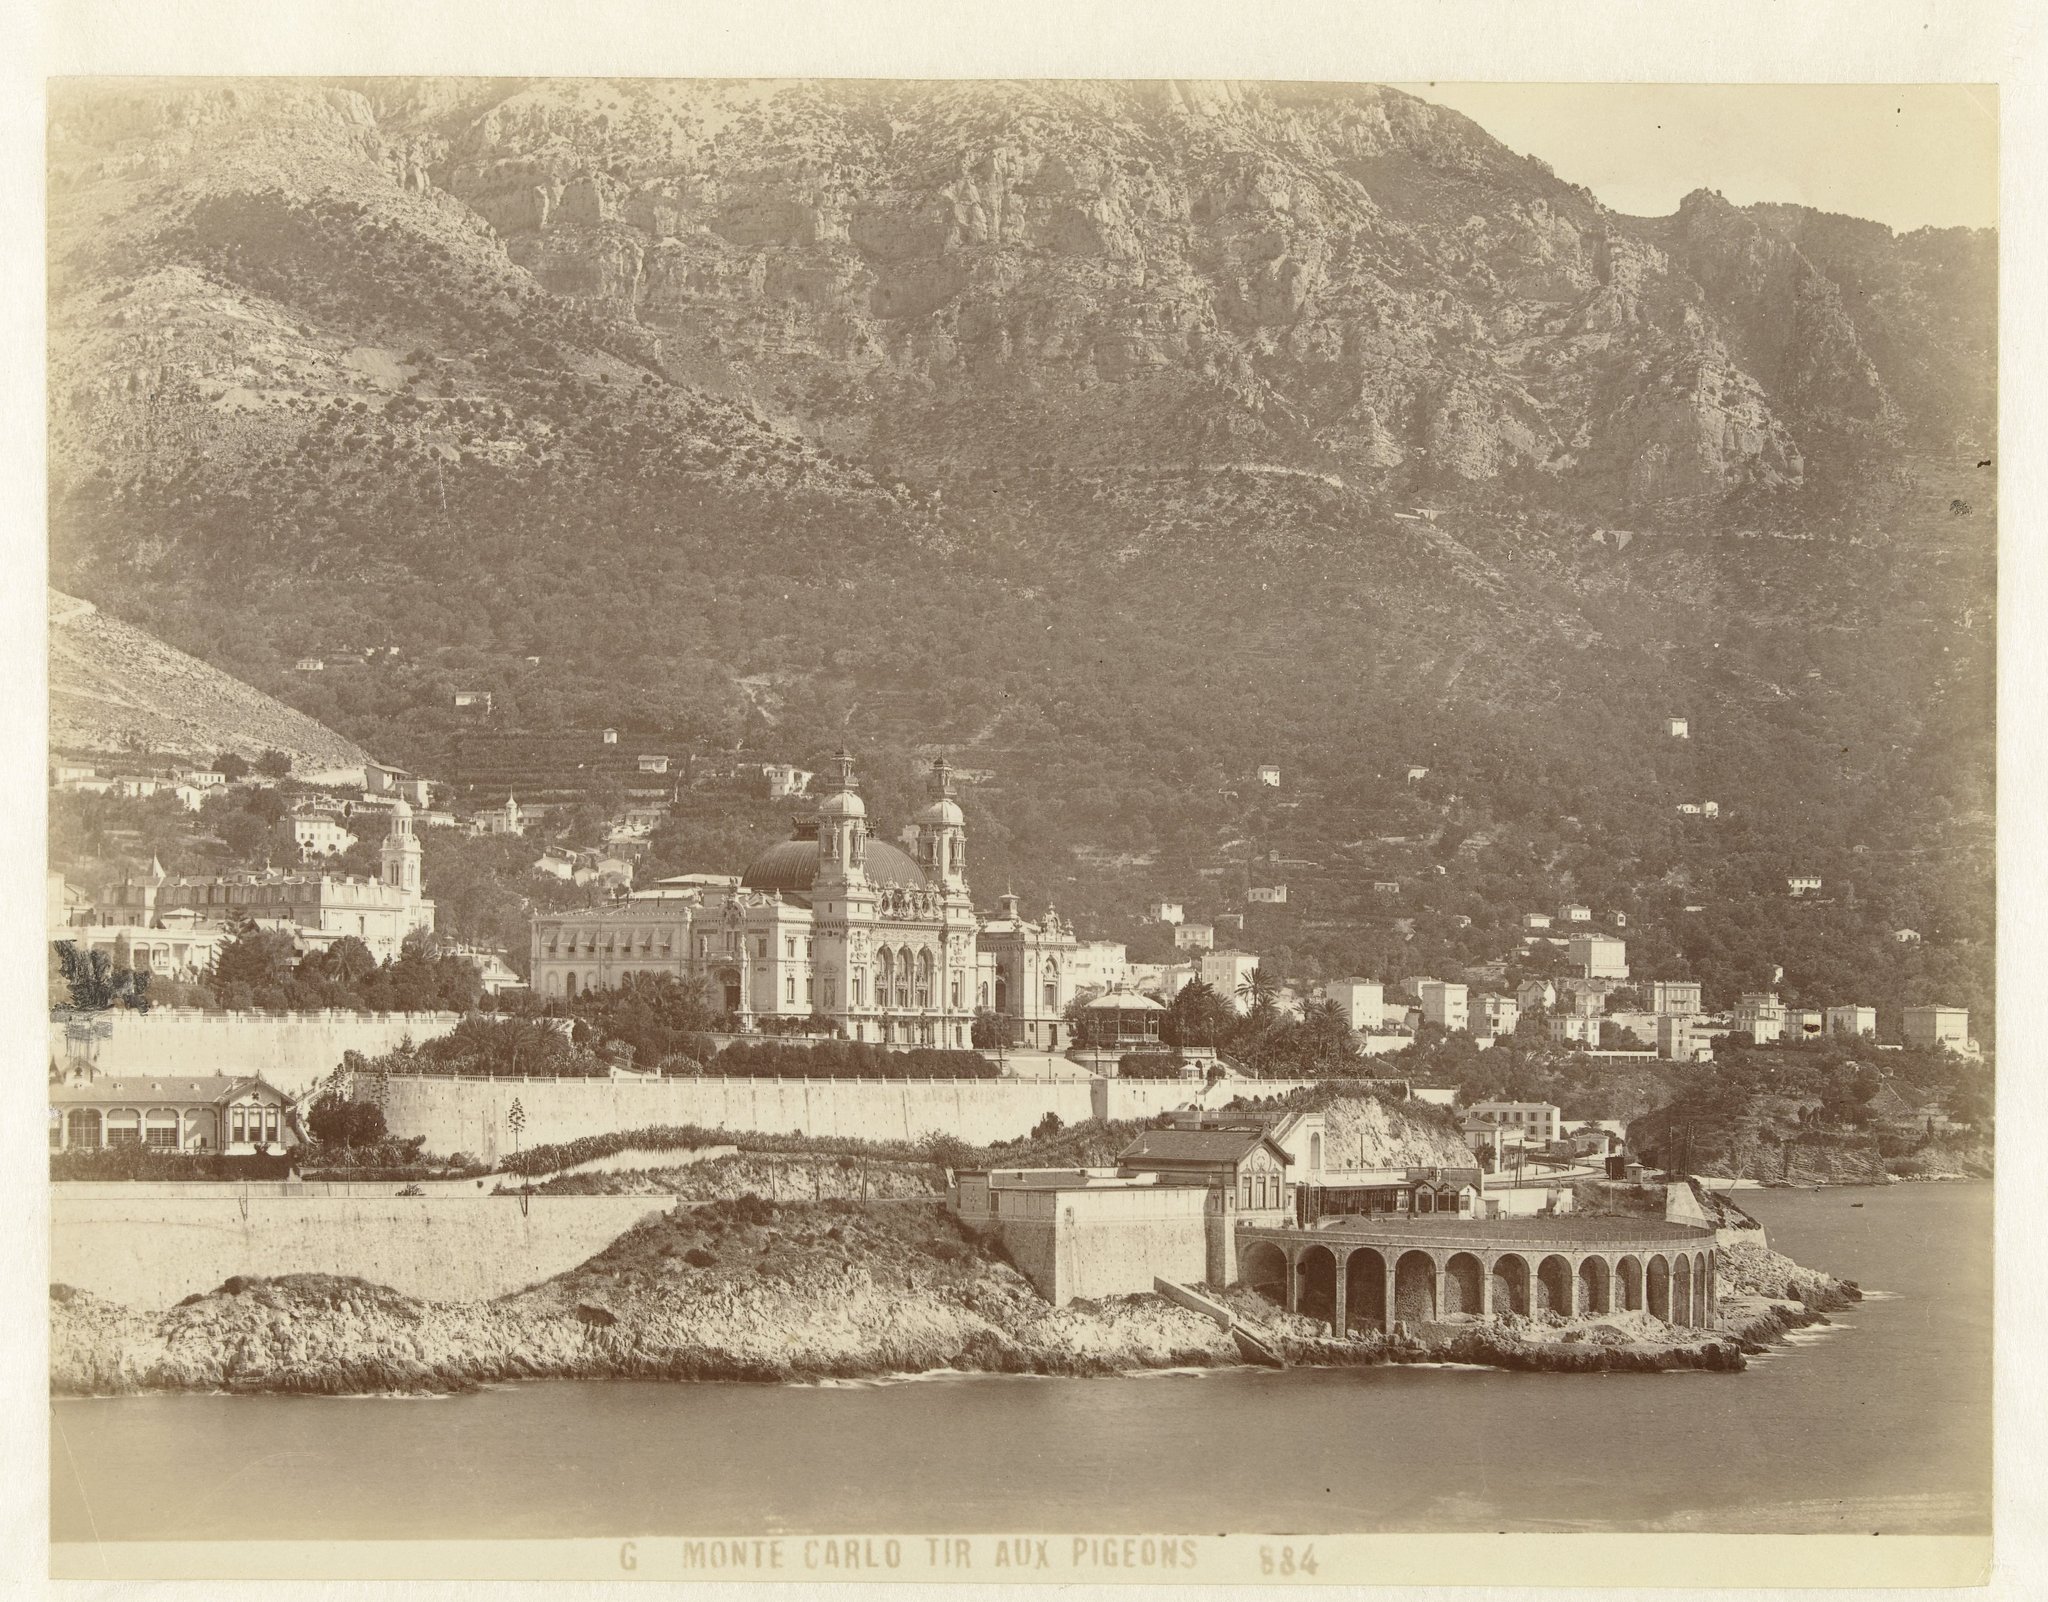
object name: photograph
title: Gezicht op Monte Carlo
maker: Anonymous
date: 1879-1910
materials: paper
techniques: albumen print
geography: monte carlo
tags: city-view in general; 'veduta', casino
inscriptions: inscription: ‘G Monte Carlo Tir aux Pigeons884’